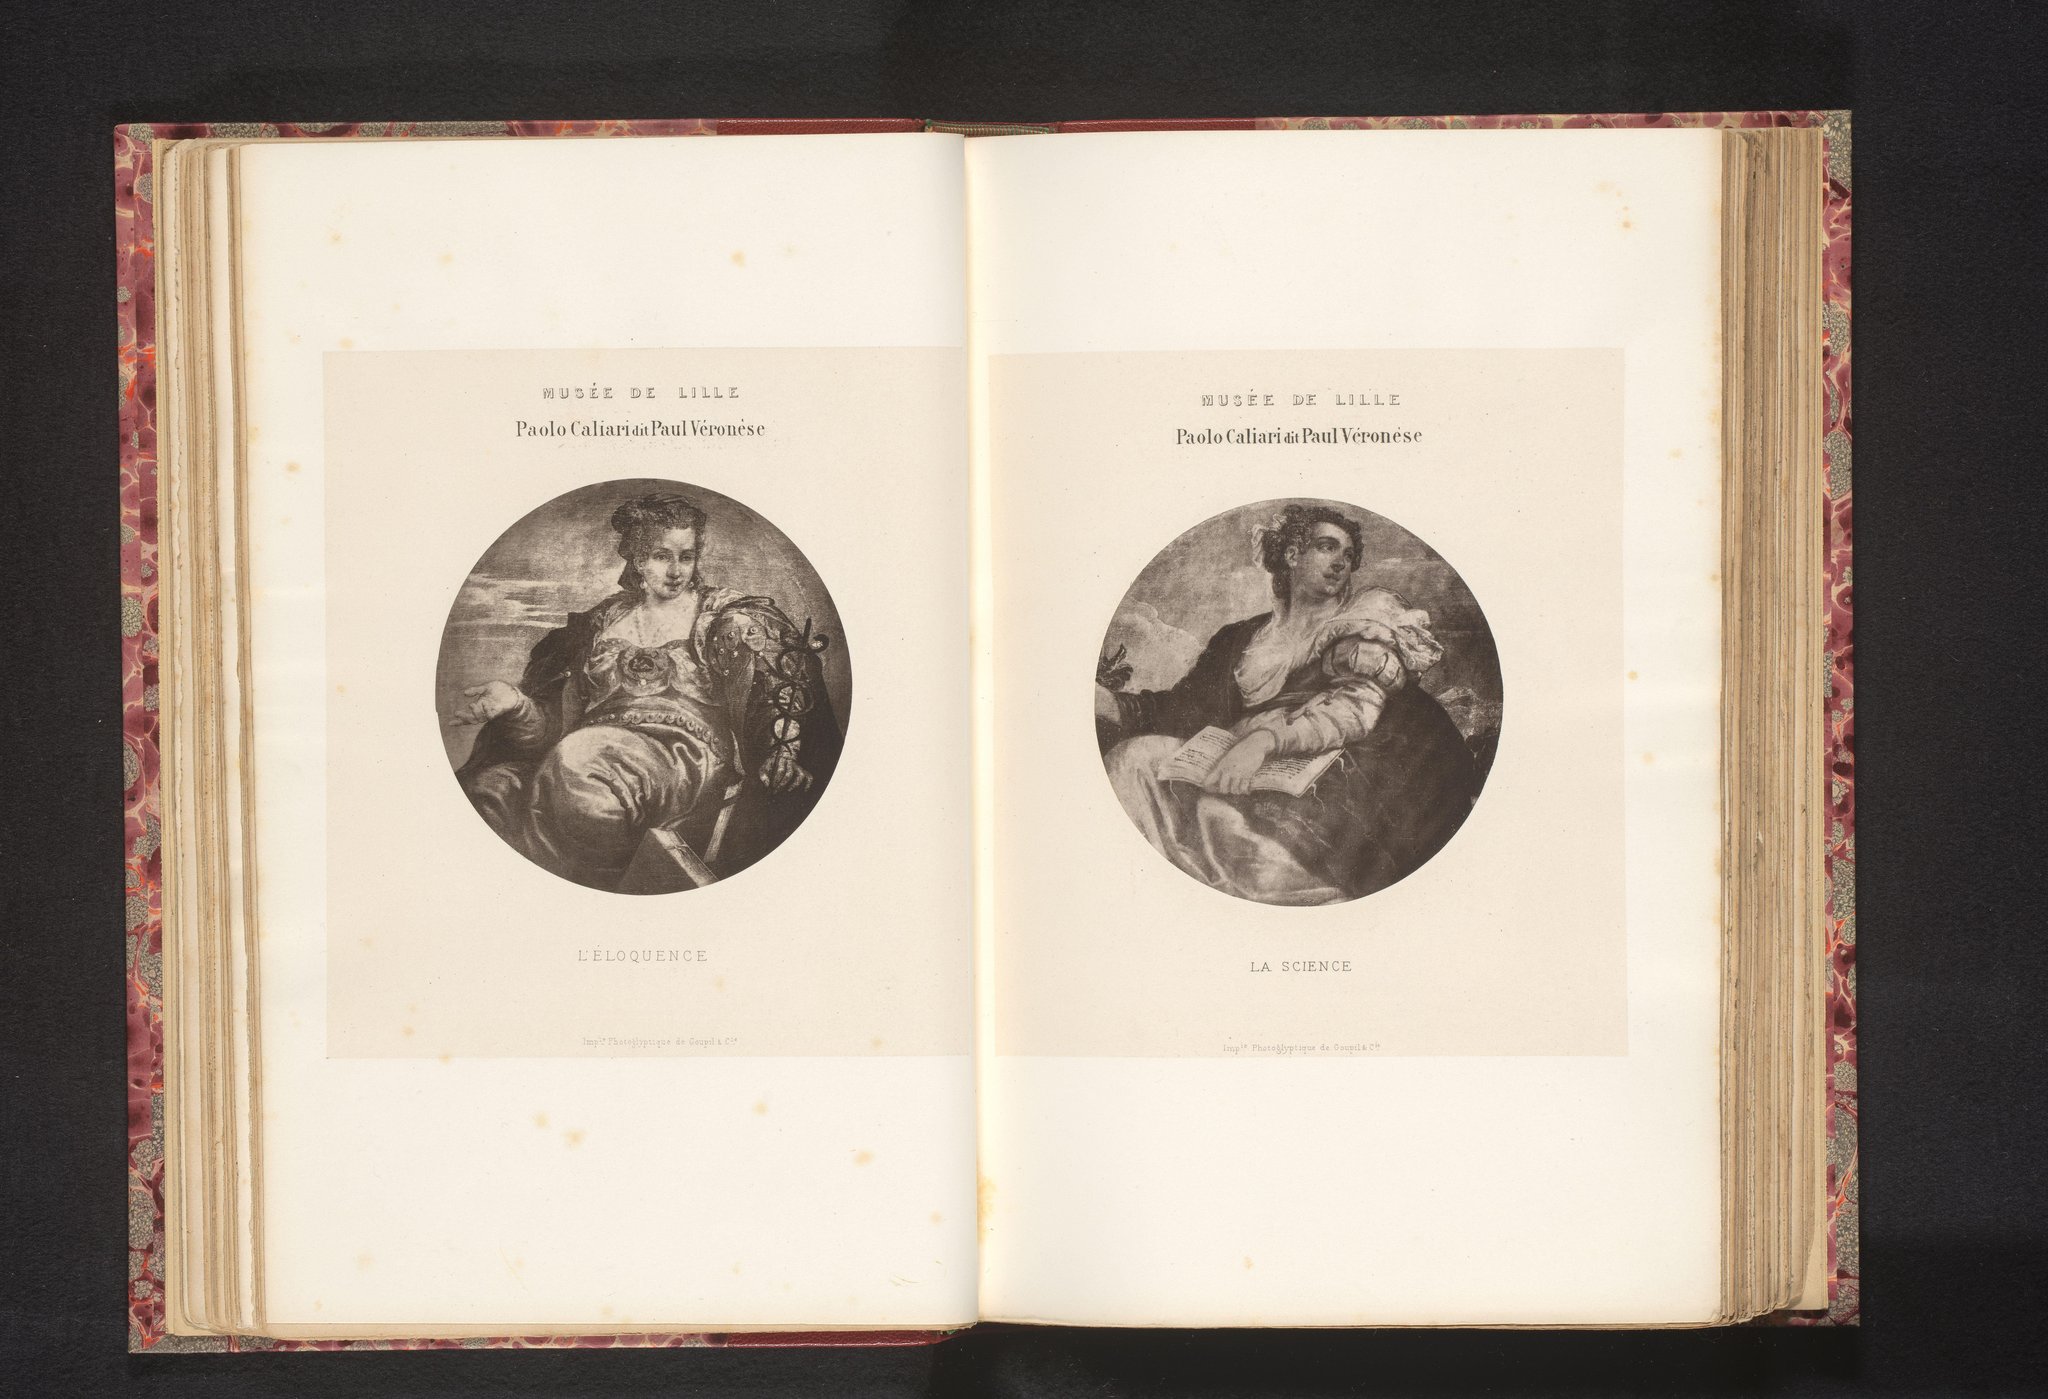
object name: reproduction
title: Fotoreproductie van een schilderij mogelijk door Paolo Veronese, voorstellend een vrouwelijke personificatie van de welsprekendheid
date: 1862-1872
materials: paper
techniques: woodburytype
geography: lille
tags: eloquence; 'eloquenza', 'fermezza & gravità dell'oratione' (ripa)